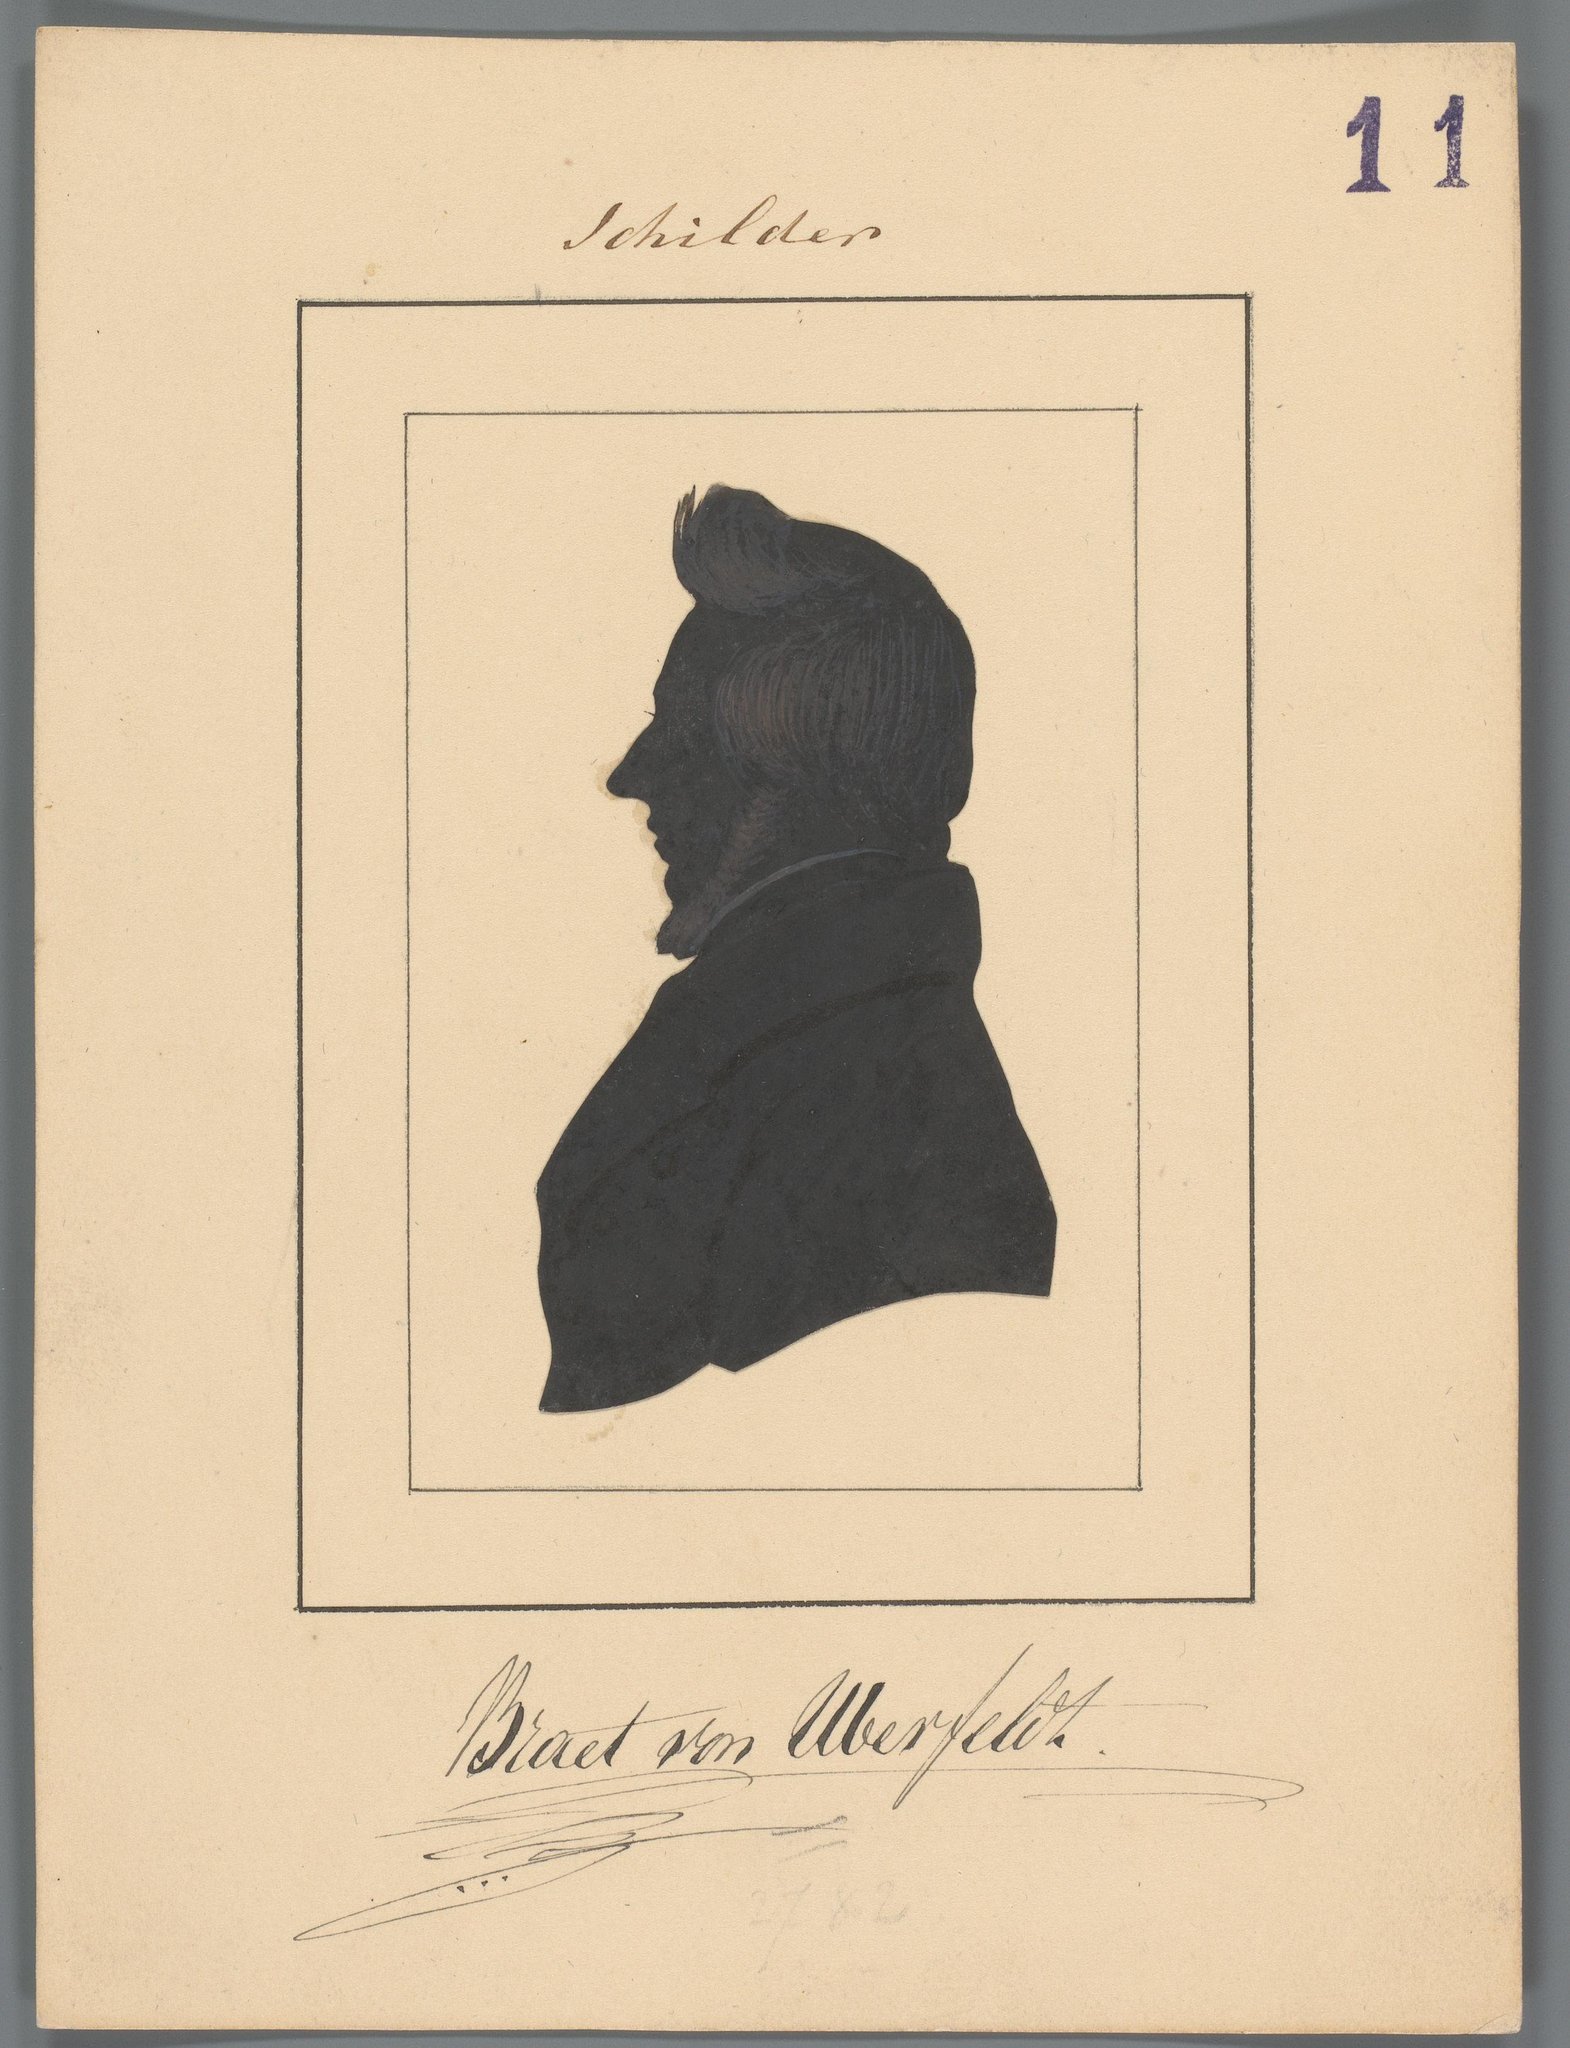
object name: drawing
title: Silhouetportret van Jan Braet von Uberfeldt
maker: elisabeth alida haanen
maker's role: draughtsman, print maker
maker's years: 1809-1845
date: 1819-1845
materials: ink, paint, paper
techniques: brush, snipping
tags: langerak, jan braet von uberfeldt, historical persons, portrait, self-portrait of painter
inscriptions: collector's mark: ‘Ex-libris van Beresteyn’, inscription: ‘Schilder’, number: ‘14024’, inscription: ‘Braet von Uberfeldt’, number: ‘11’, inscription: ‘Neg. D. 1751’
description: Met onder het portret de handtekening van de geportretteerde.